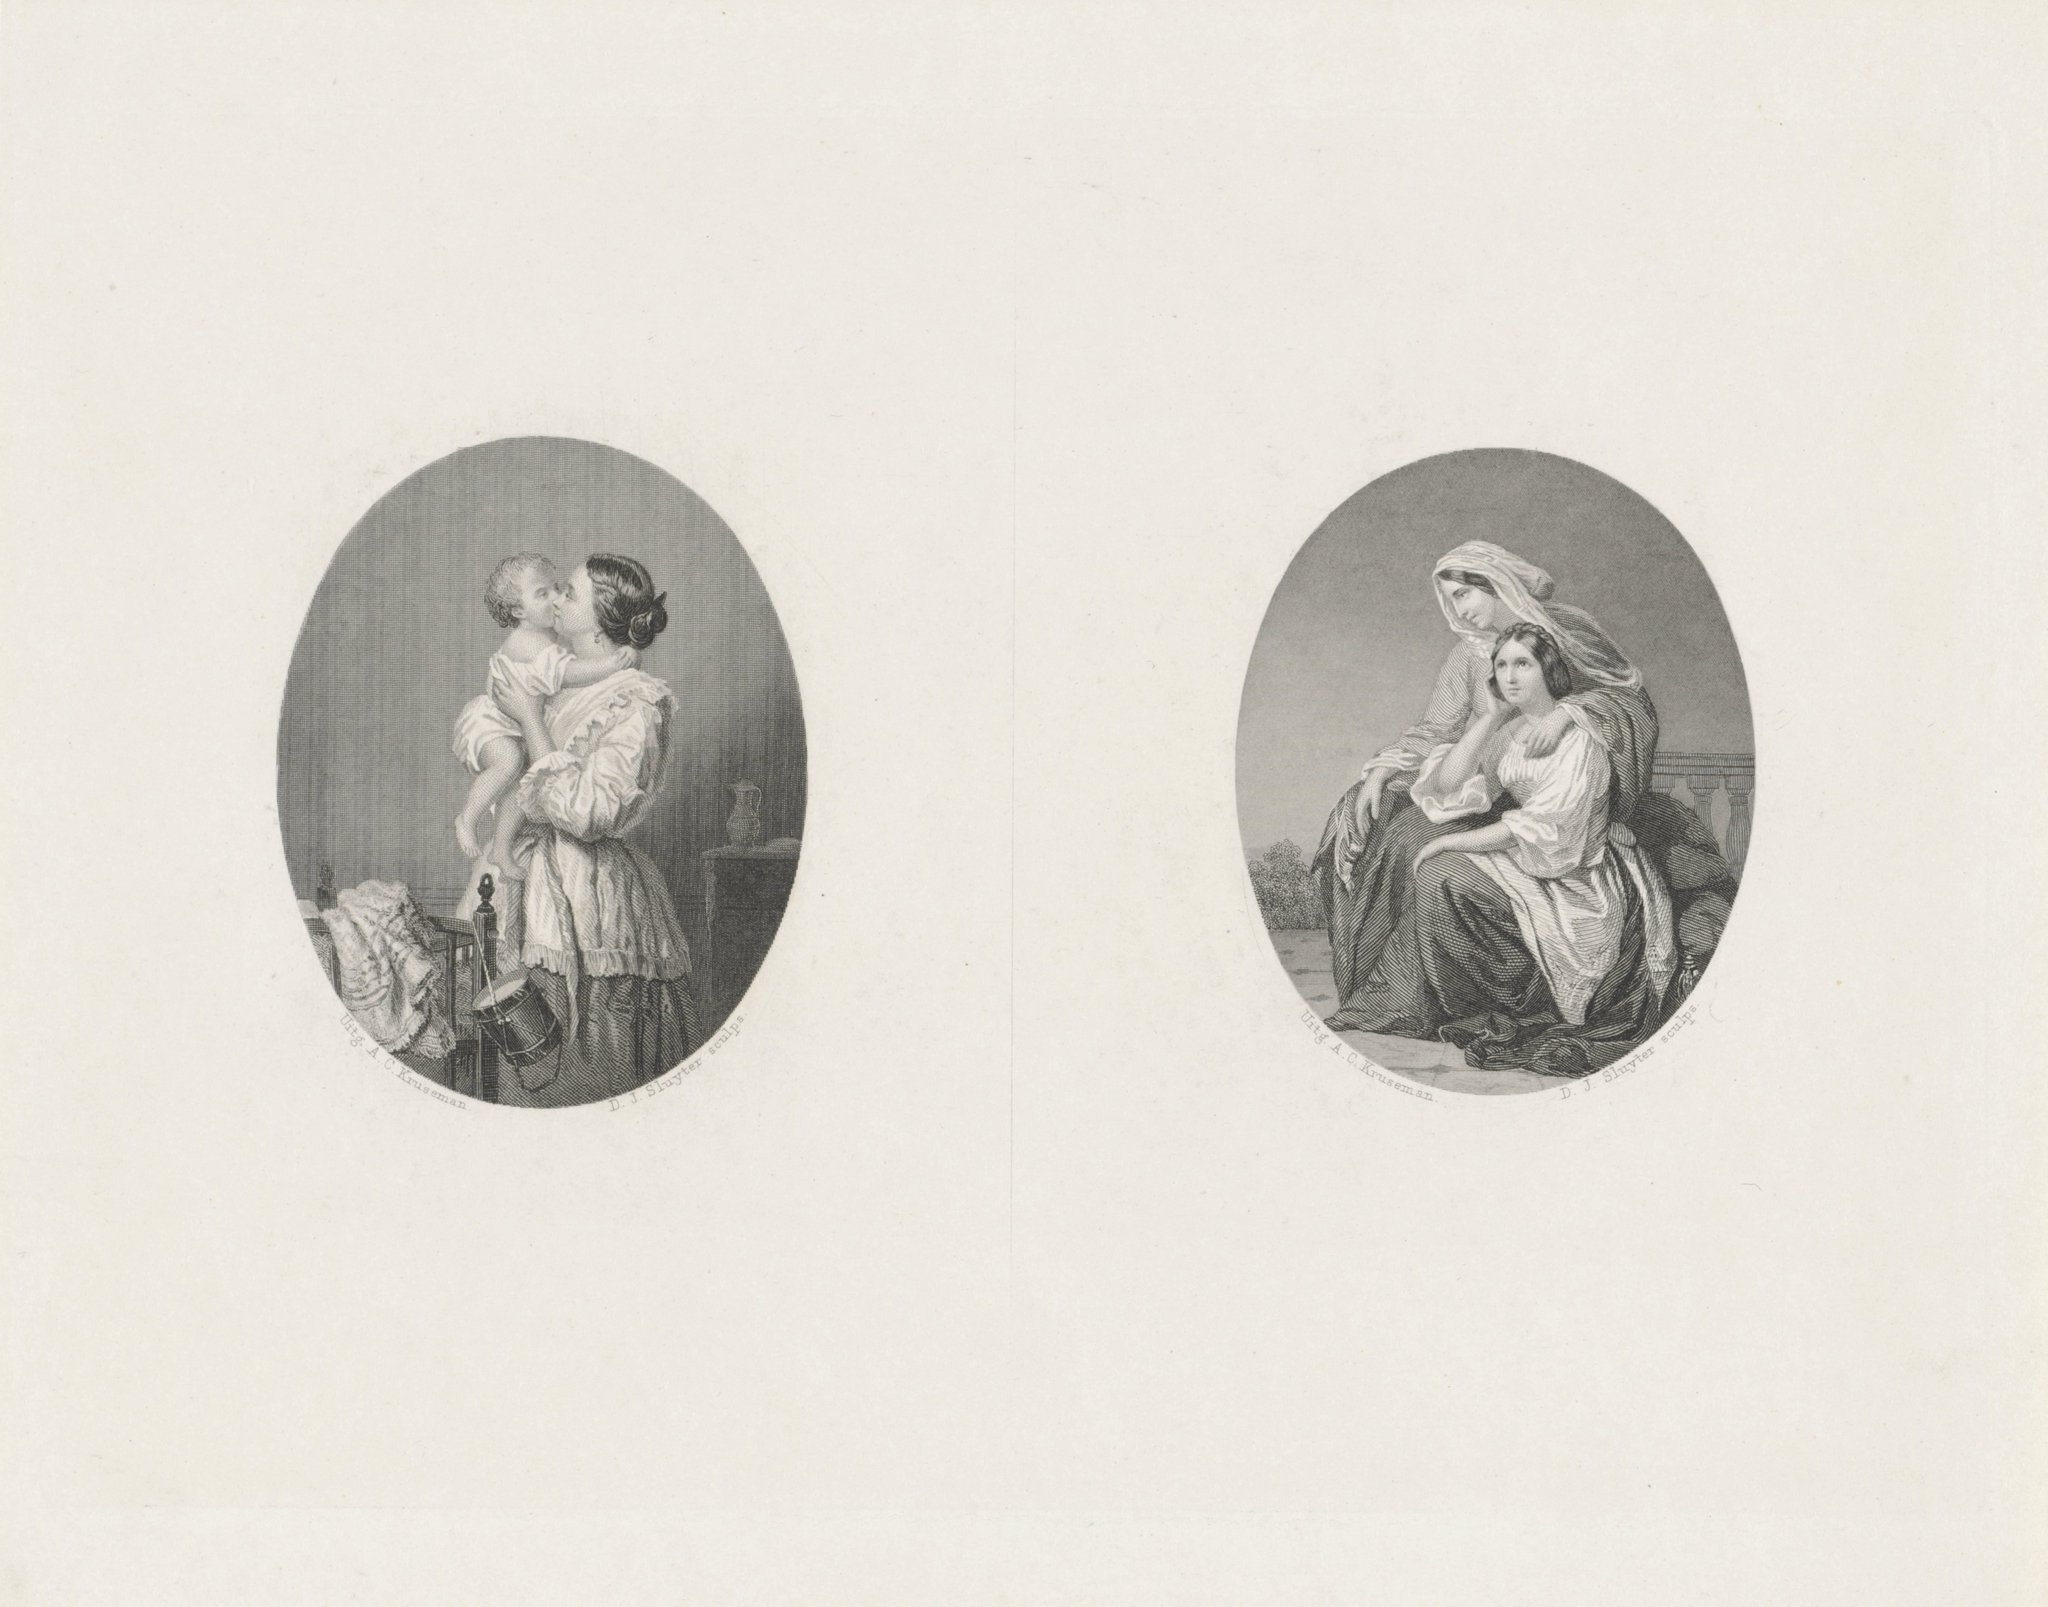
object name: book illustration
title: Moeder met kind - Vrouw met jong meisje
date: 1842-1873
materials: paper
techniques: engraving, etching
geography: amsterdam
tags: mother playing with baby (fondling, dandling, crooning), drum (musical instrument), cradle, crib, mother and baby or young child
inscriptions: collector's mark: Lugt 2228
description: Twee boekillustraties op een plaat. Links een moeder die haar dreumes knuffelt. Zij staat naast het ledikantje, waaraan een trommel hangt. Rechts een vrouw die op een rots bij een balustrade zit. Zij heeft haar arm om de schouders van de jonge vrouw naast haar geslagen.